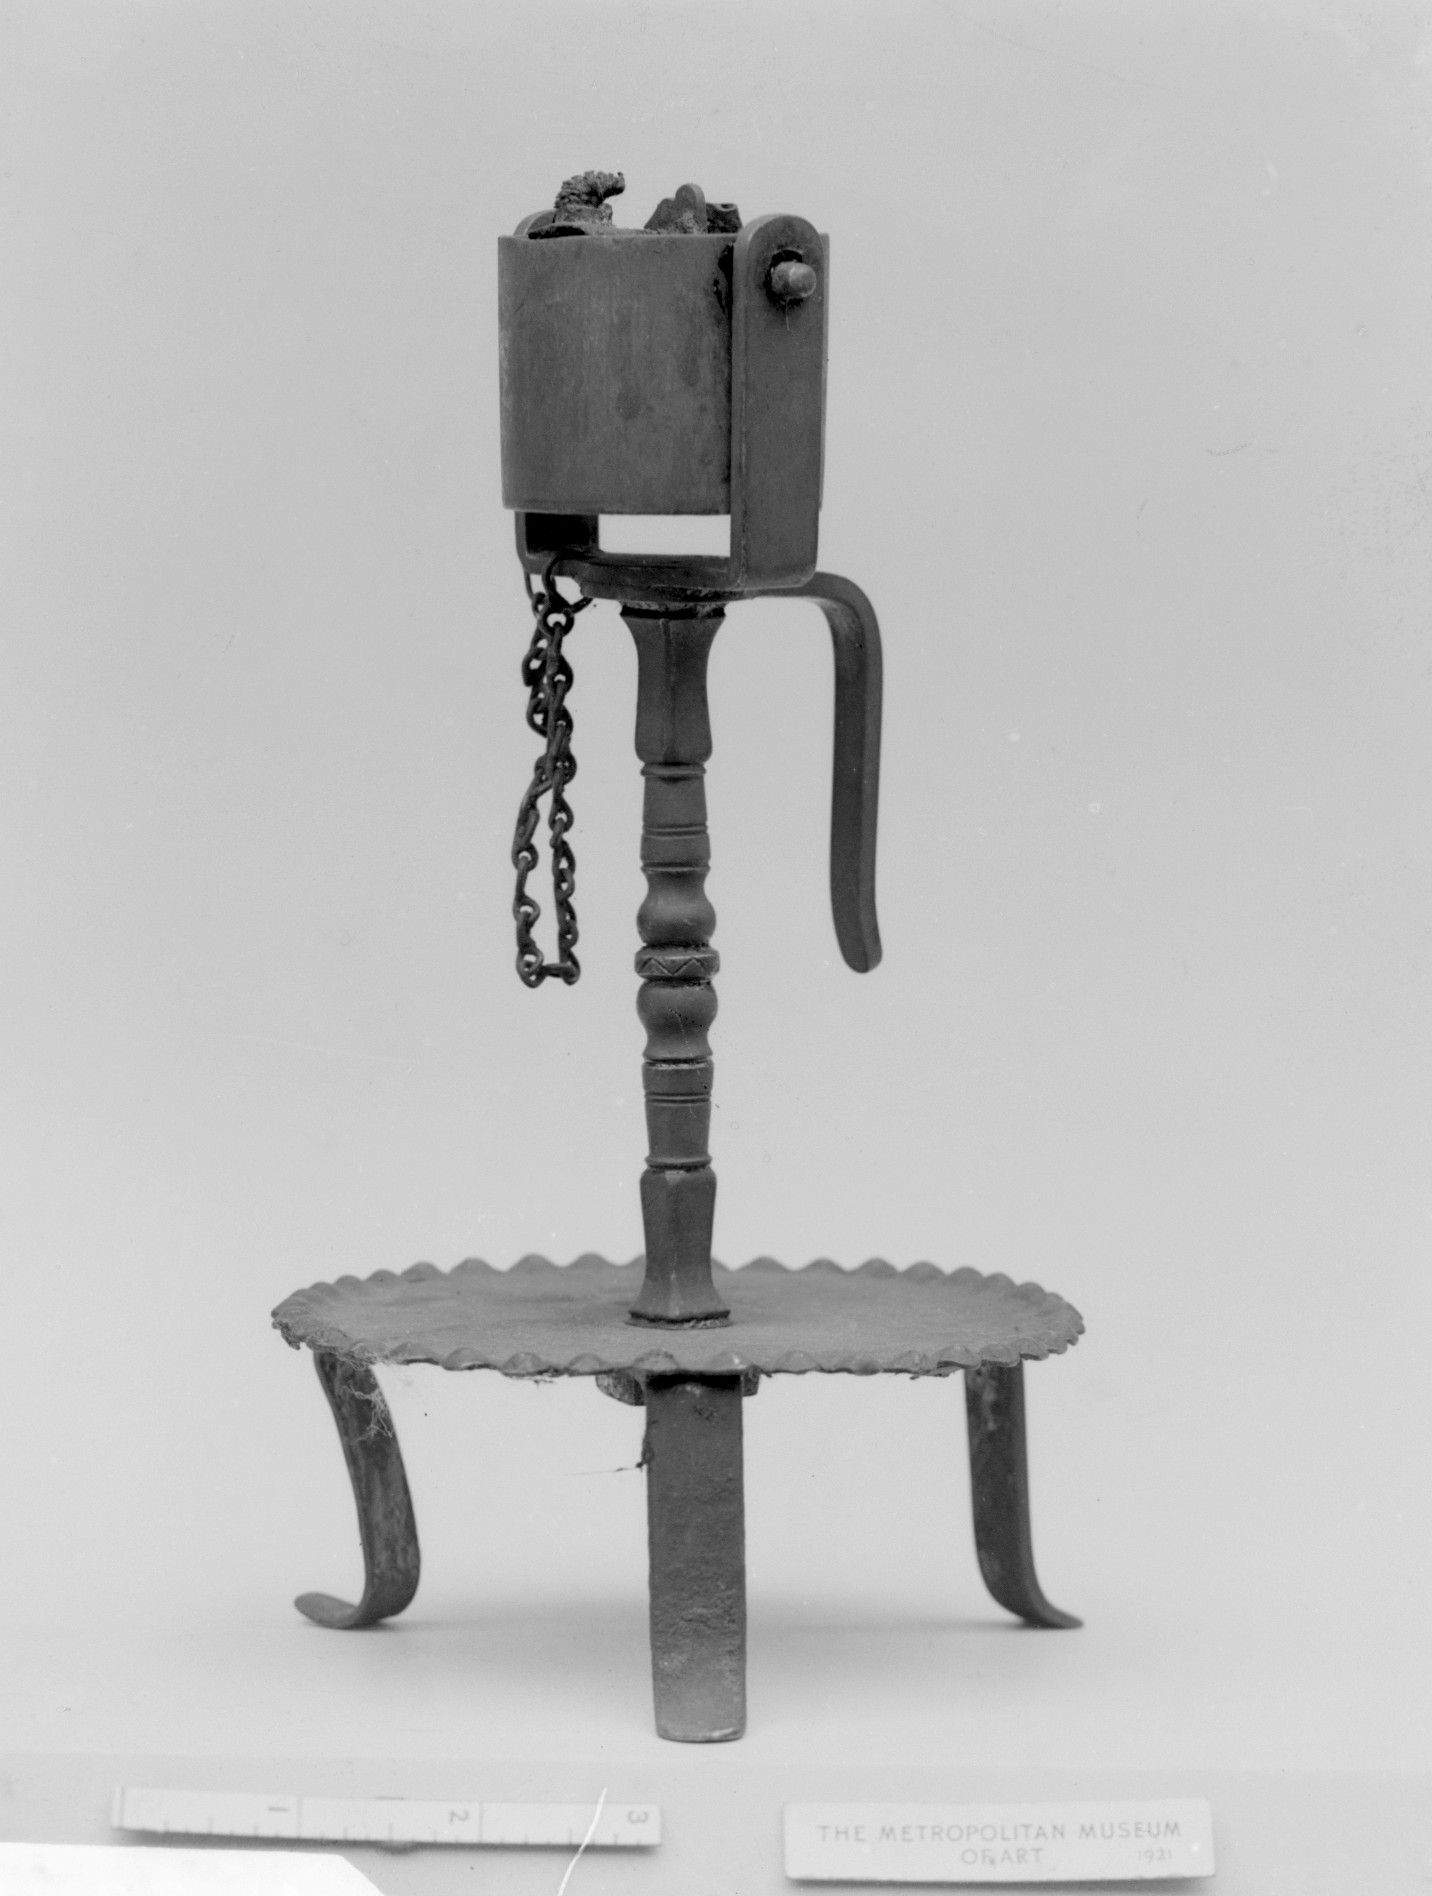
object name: portable lamp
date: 1601-1700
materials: iron